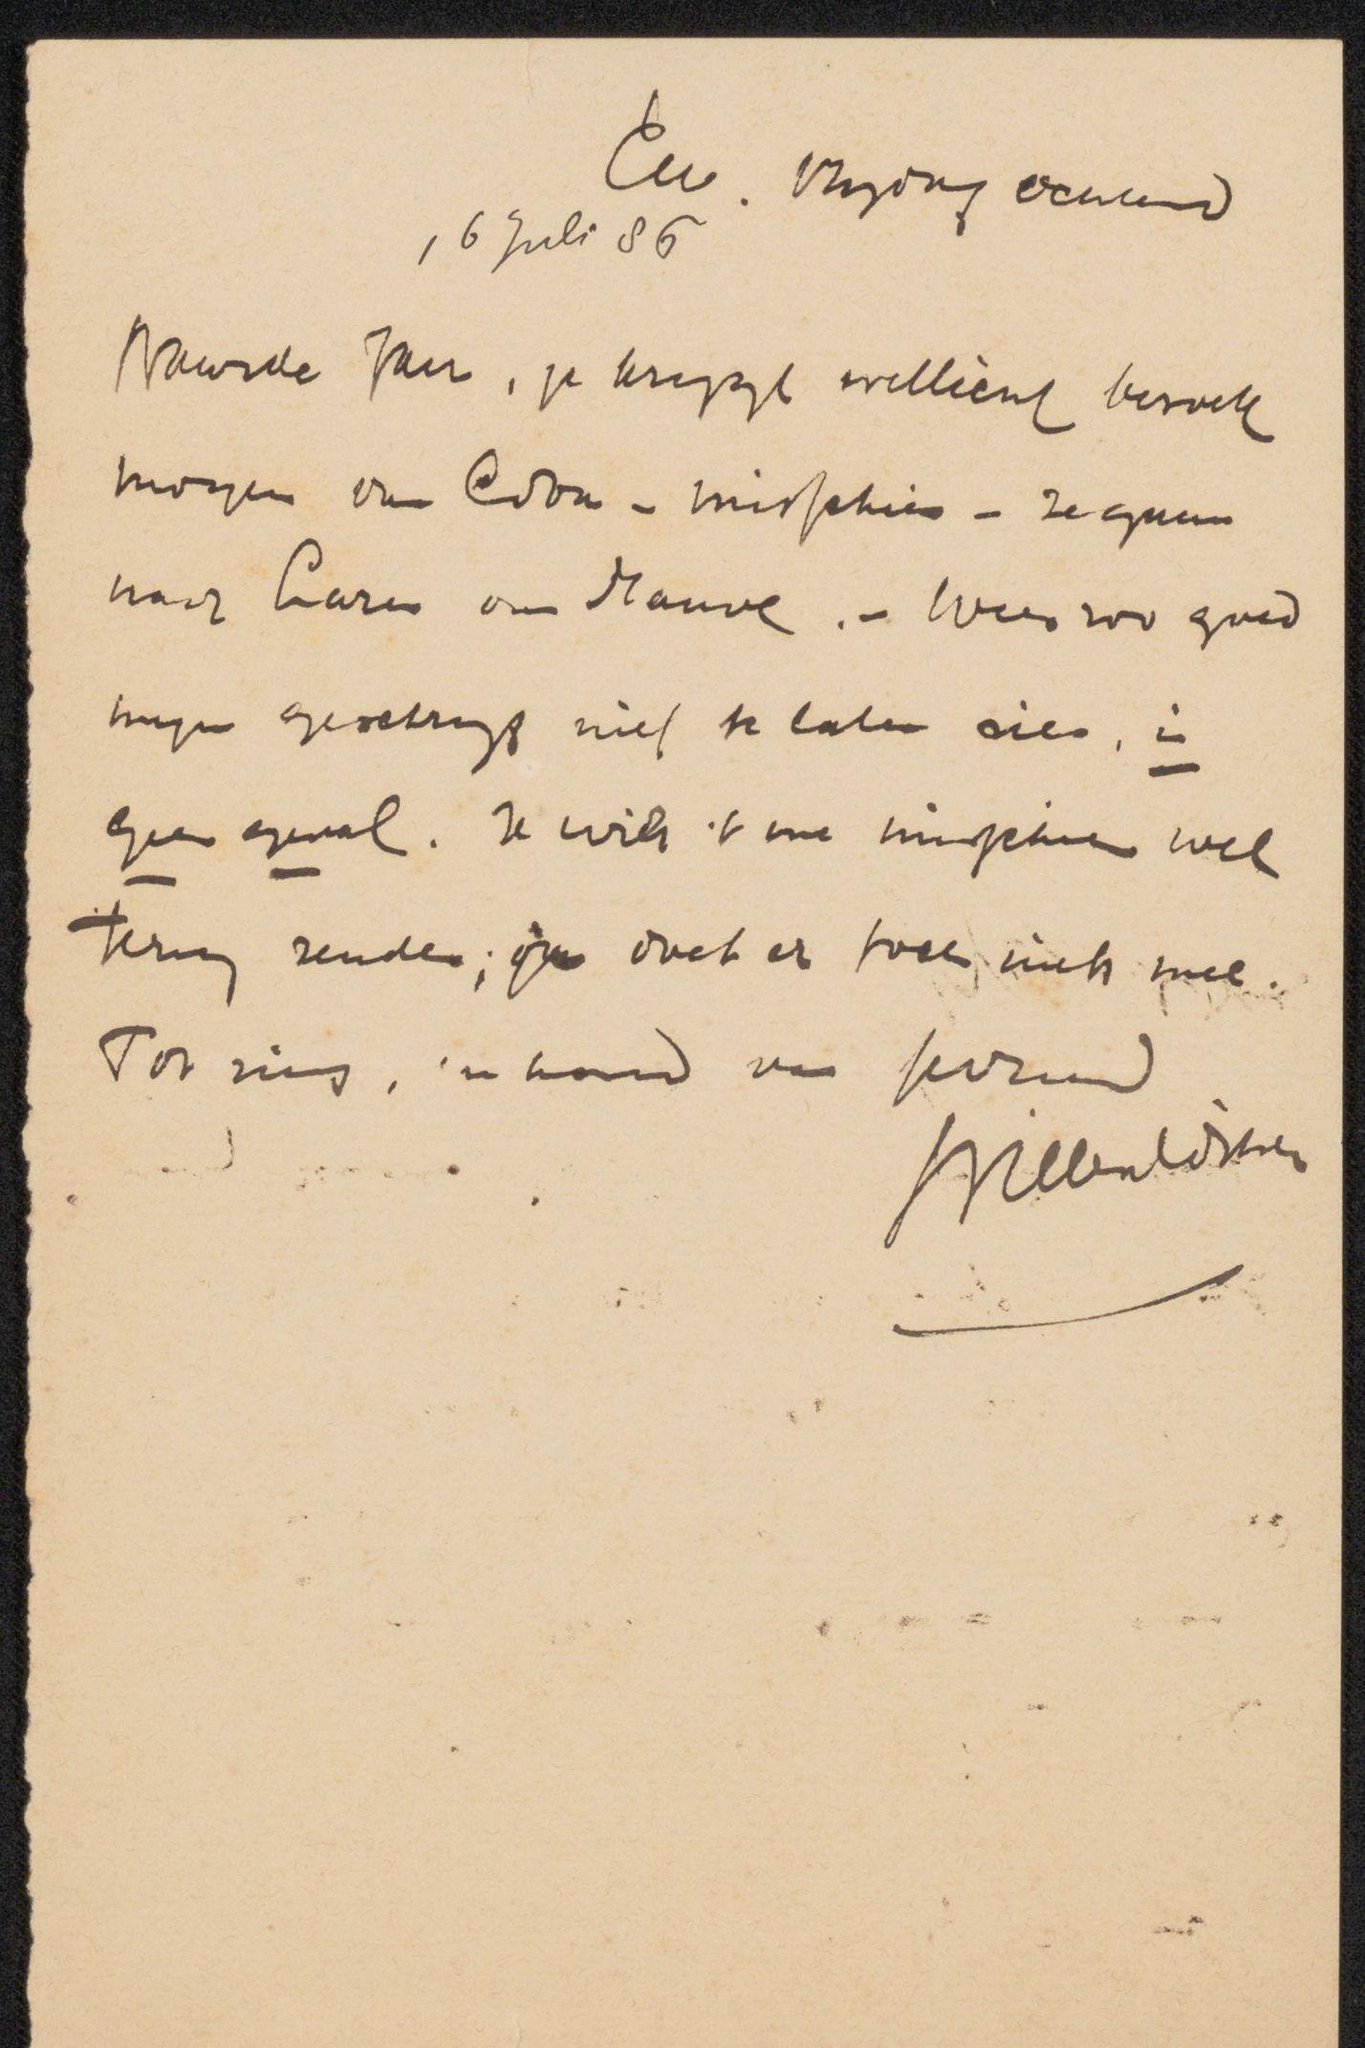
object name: letter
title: Brief aan Jan Veth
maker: willem witsen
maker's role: draughtsman, painter, print maker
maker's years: 1860-1923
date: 1874-1923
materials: ink, paper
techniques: pen, writing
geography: ewijkshoeve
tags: designer, jan veth, arnhem, painter, print maker, draughtsman, anton mauve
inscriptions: watermark, collector's mark: ‘RPK’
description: Brief gedateerd 16 Juli 86 in latere hand.